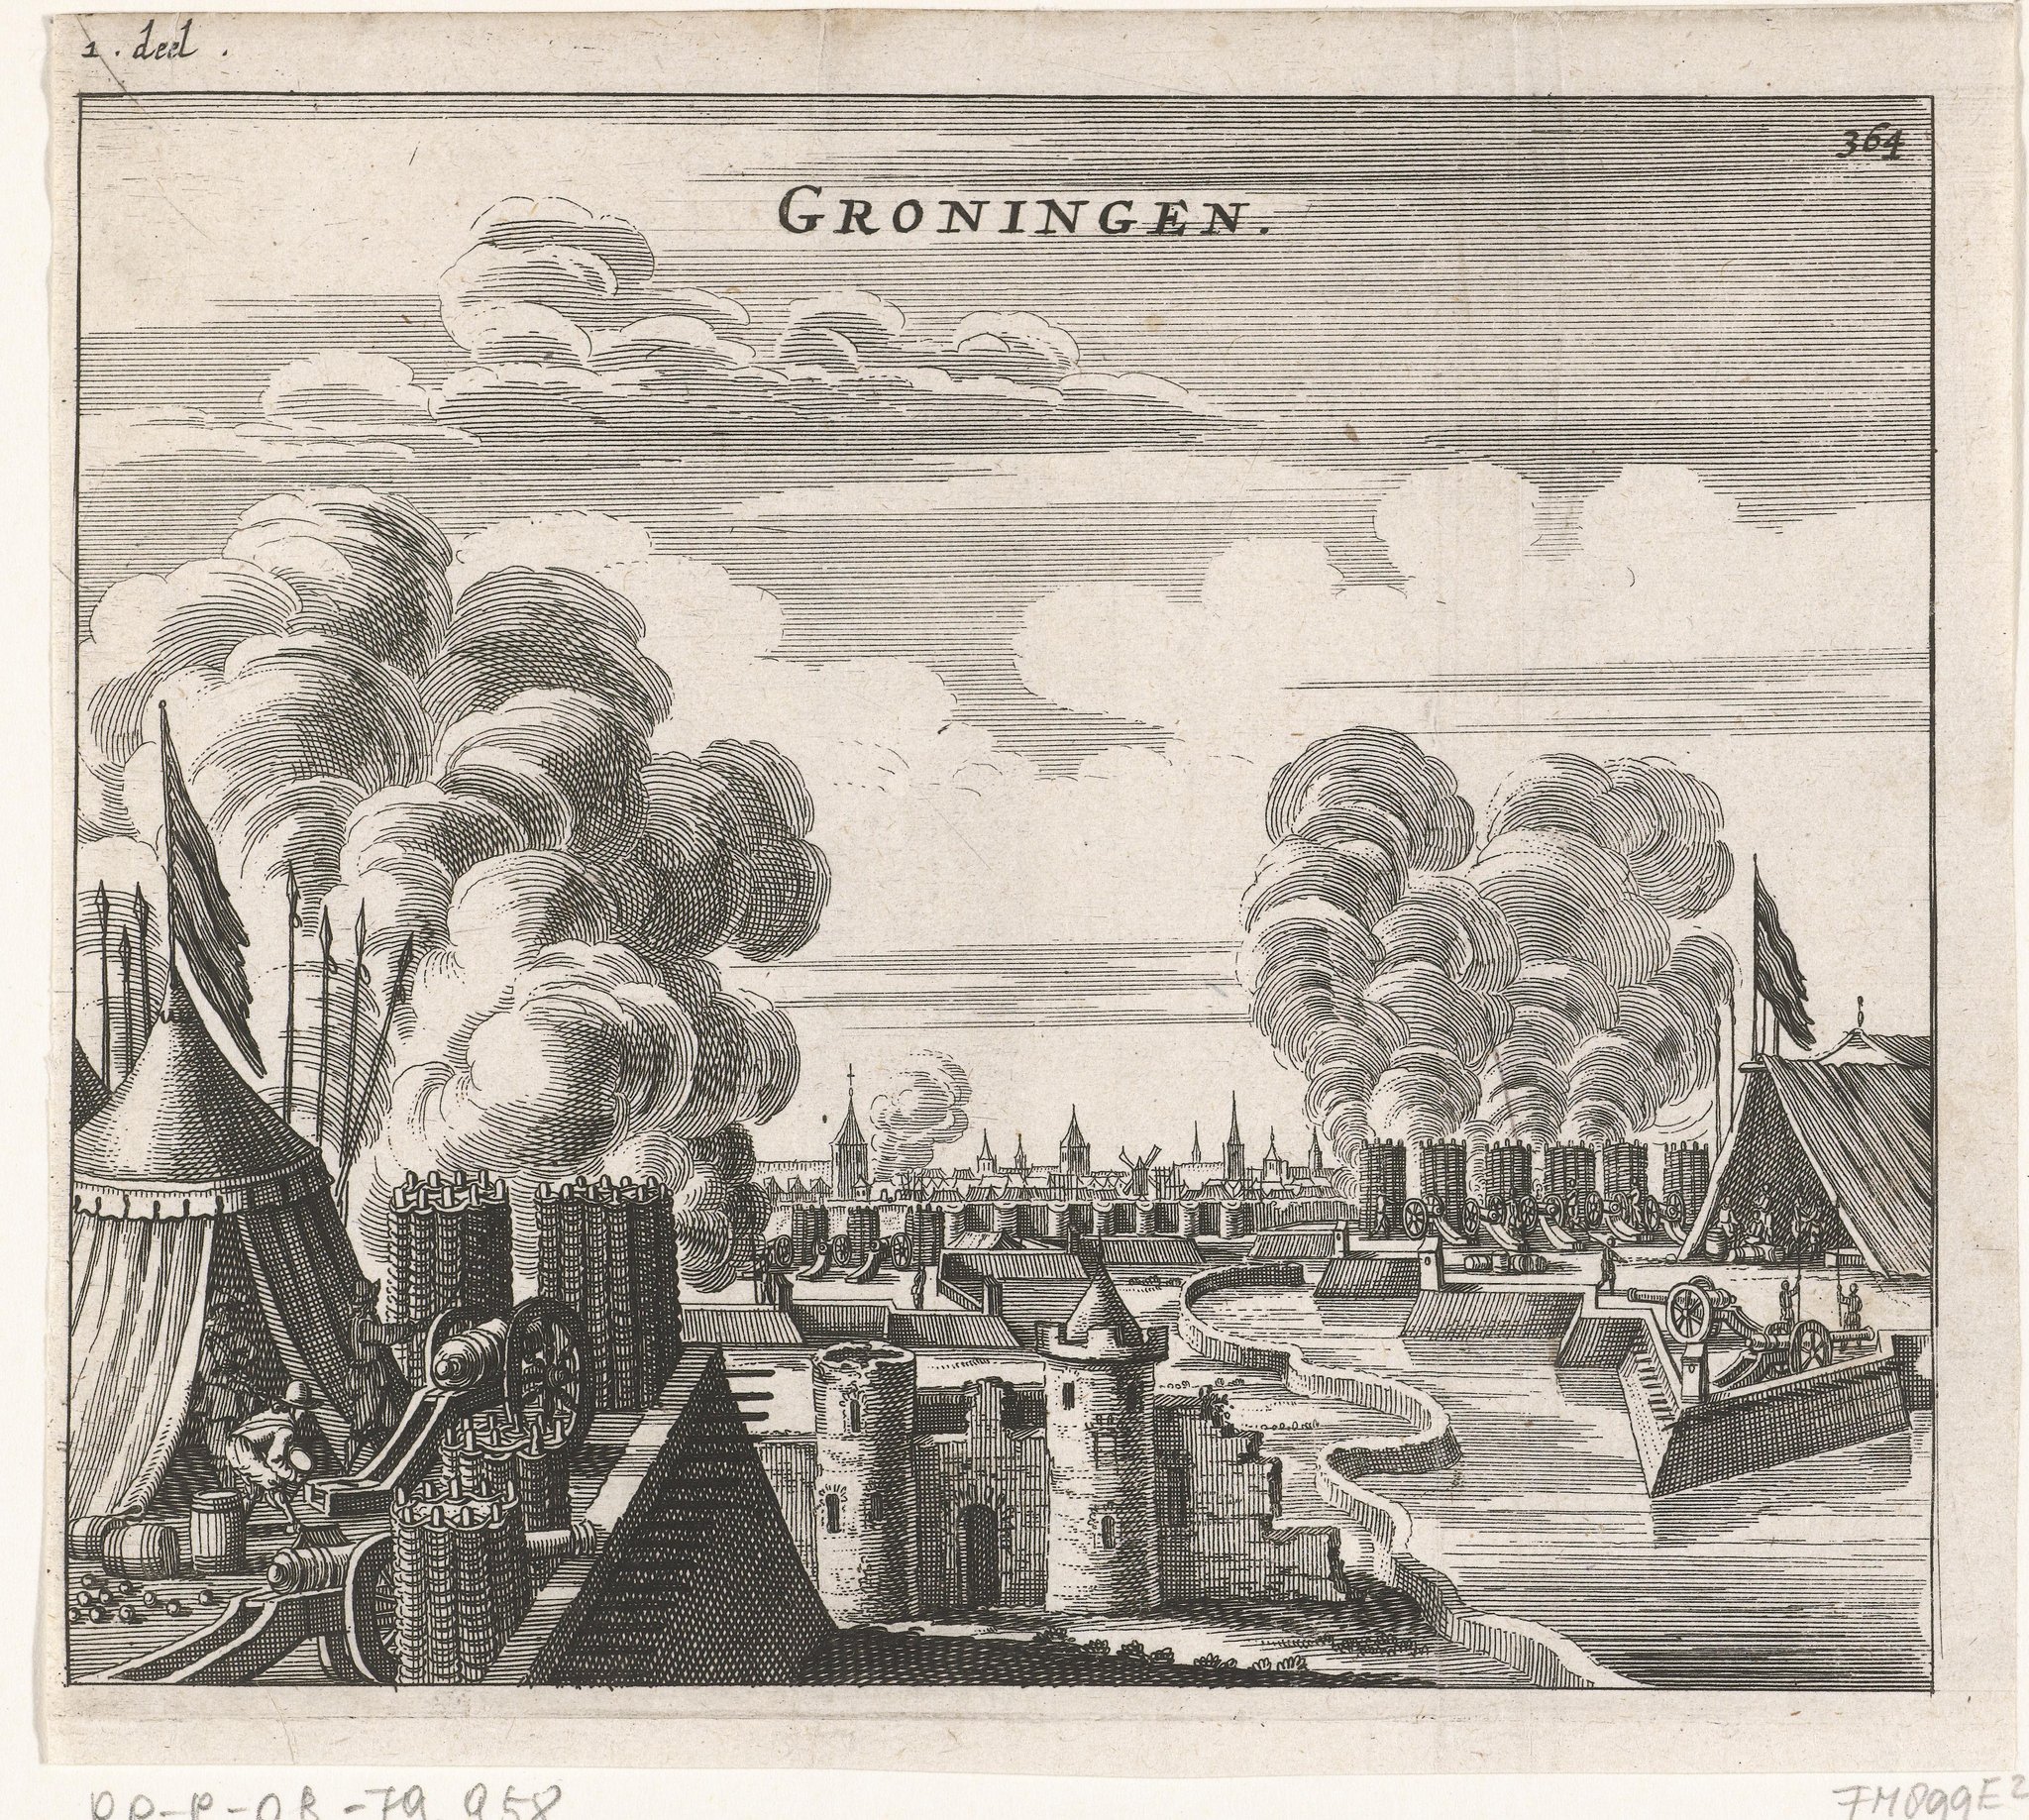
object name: history print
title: Beleg van Groningen, 1594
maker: Anonymous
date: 1625-1699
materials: paper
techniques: etching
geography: northern netherlands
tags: siege, position war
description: Illustratie uit een onbekend werk over de militaire wapenfeiten van de prinsen van Oranje, dl. 1, p. 364.